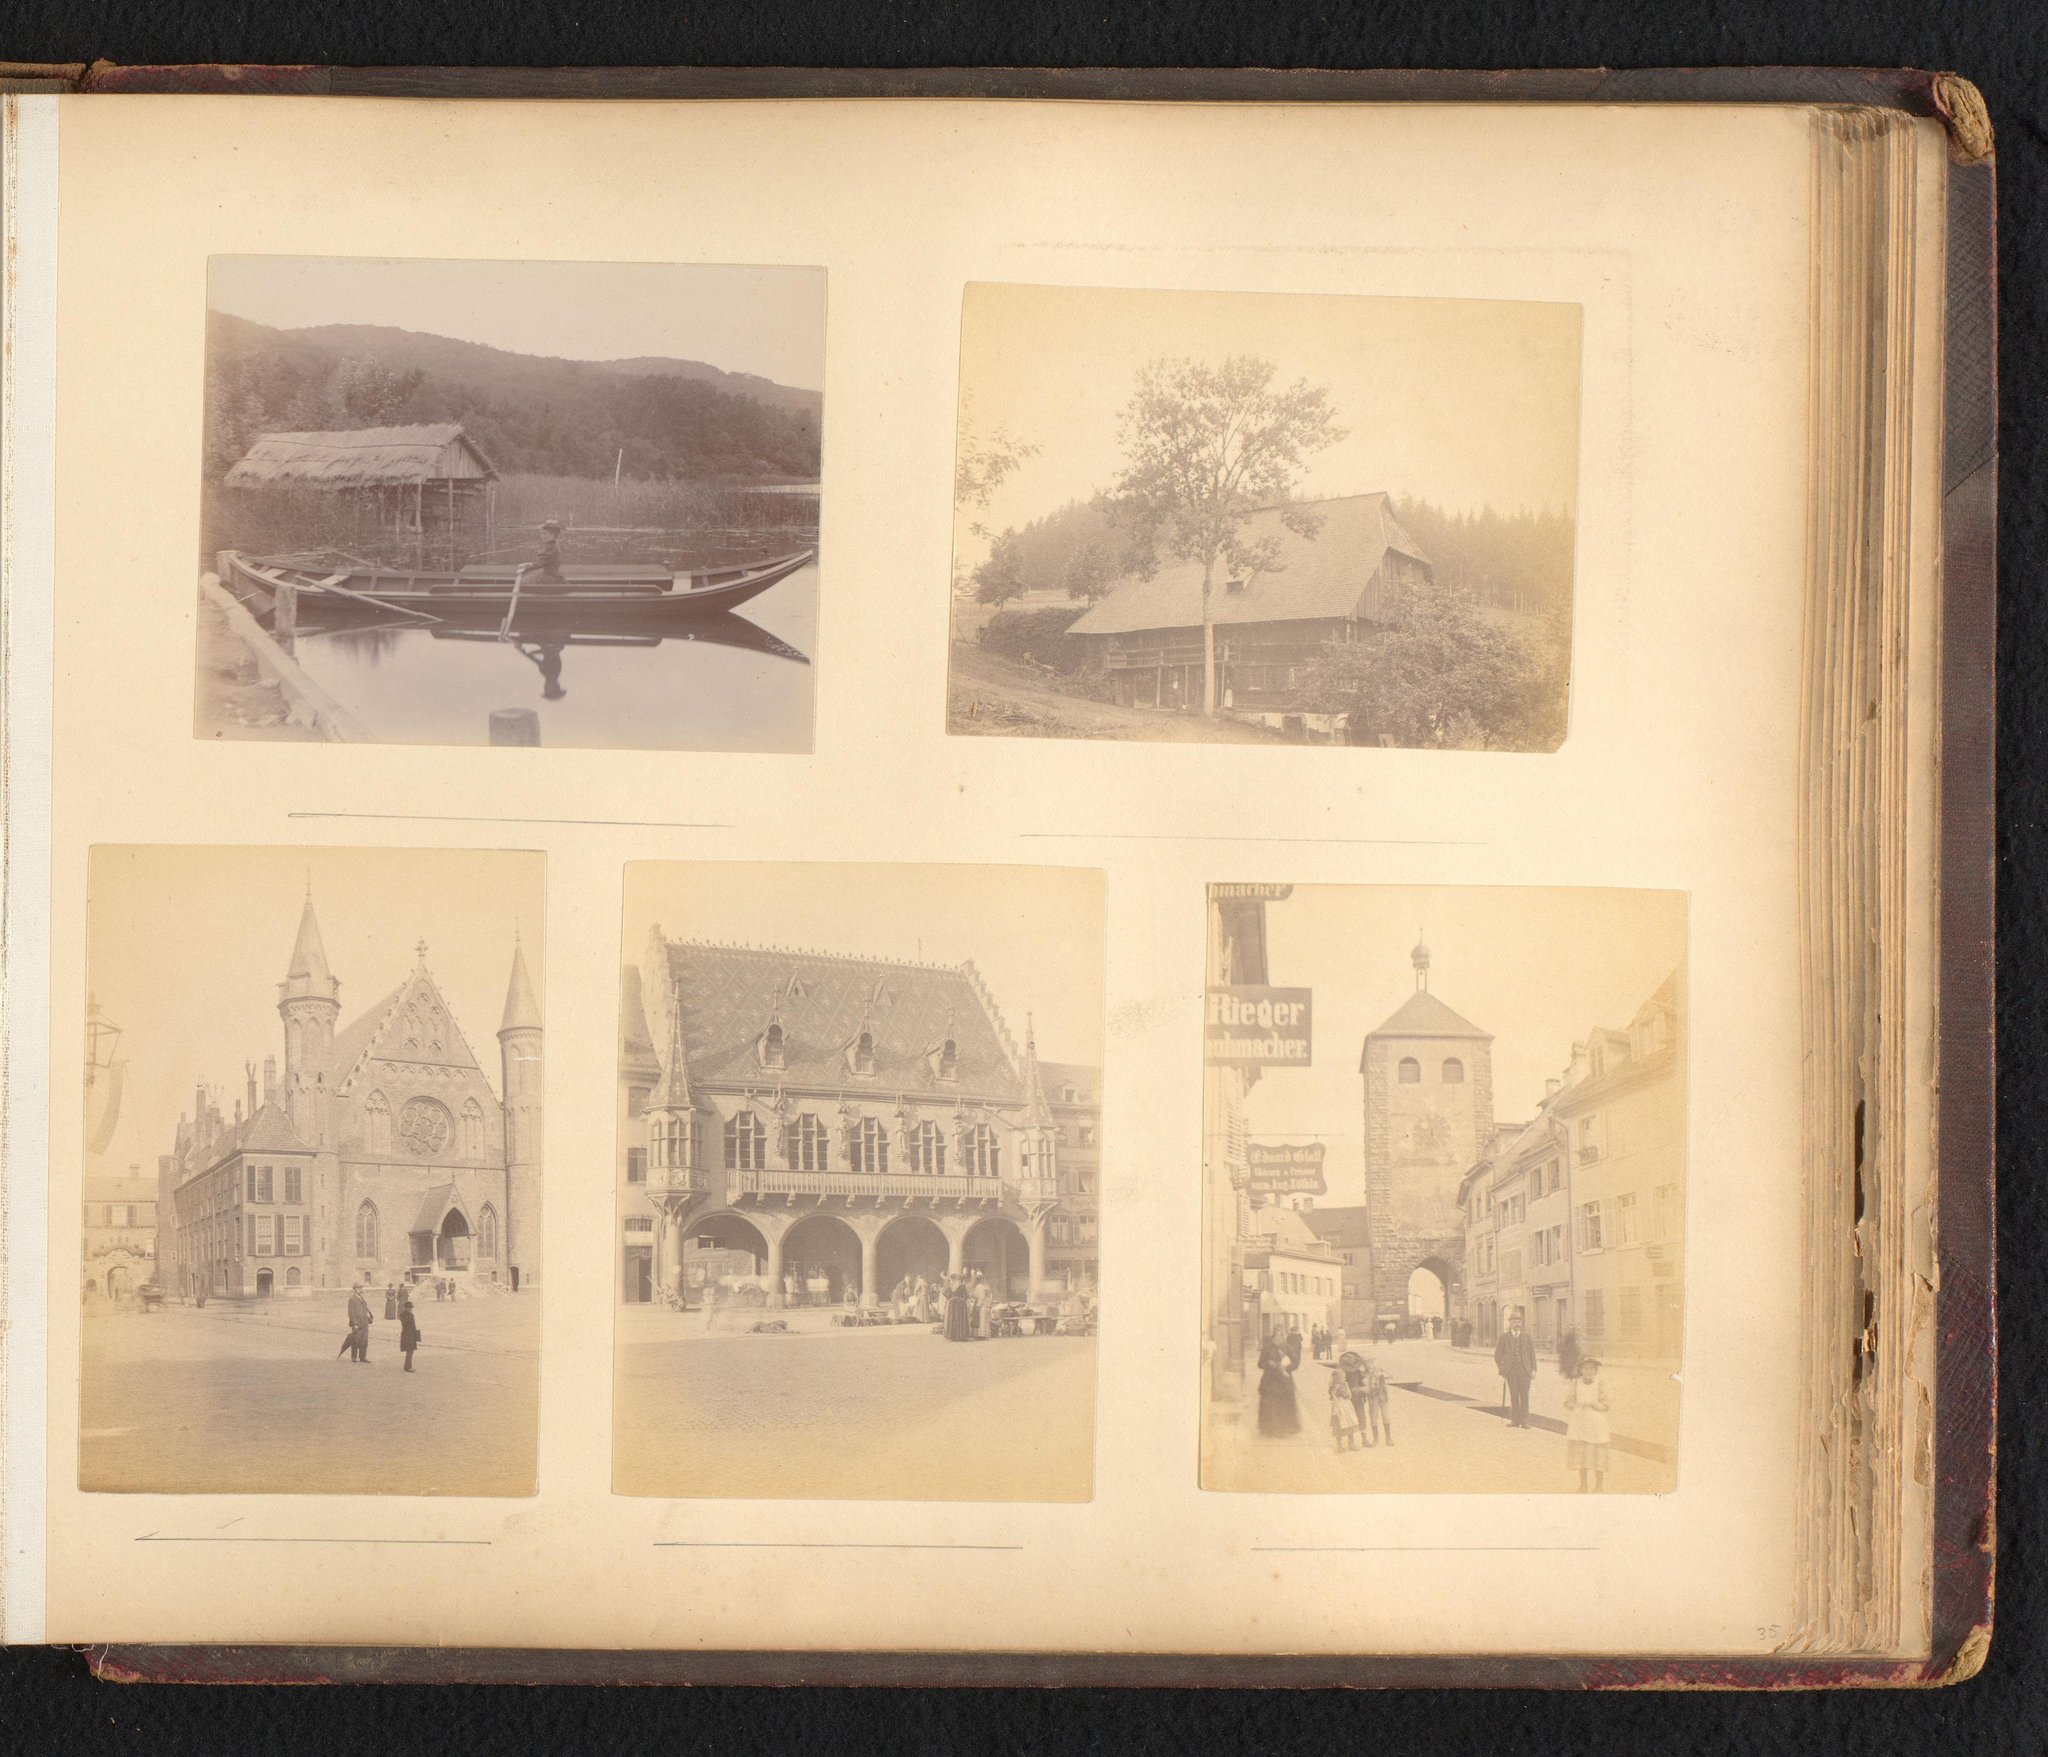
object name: album leaf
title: Diverse onderwerpen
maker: Anonymous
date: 1890-1898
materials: photographic support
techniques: albumen print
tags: adult woman, ruin of a building ~ architecture, civic architecture; edifices; dwellings - aa - civic architecture: inside, church (exterior)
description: Gezichten op een woning, een kerk, een gebouw en een toren en een roeiende vrouw. Deze pagina maakt deel uit van een album.